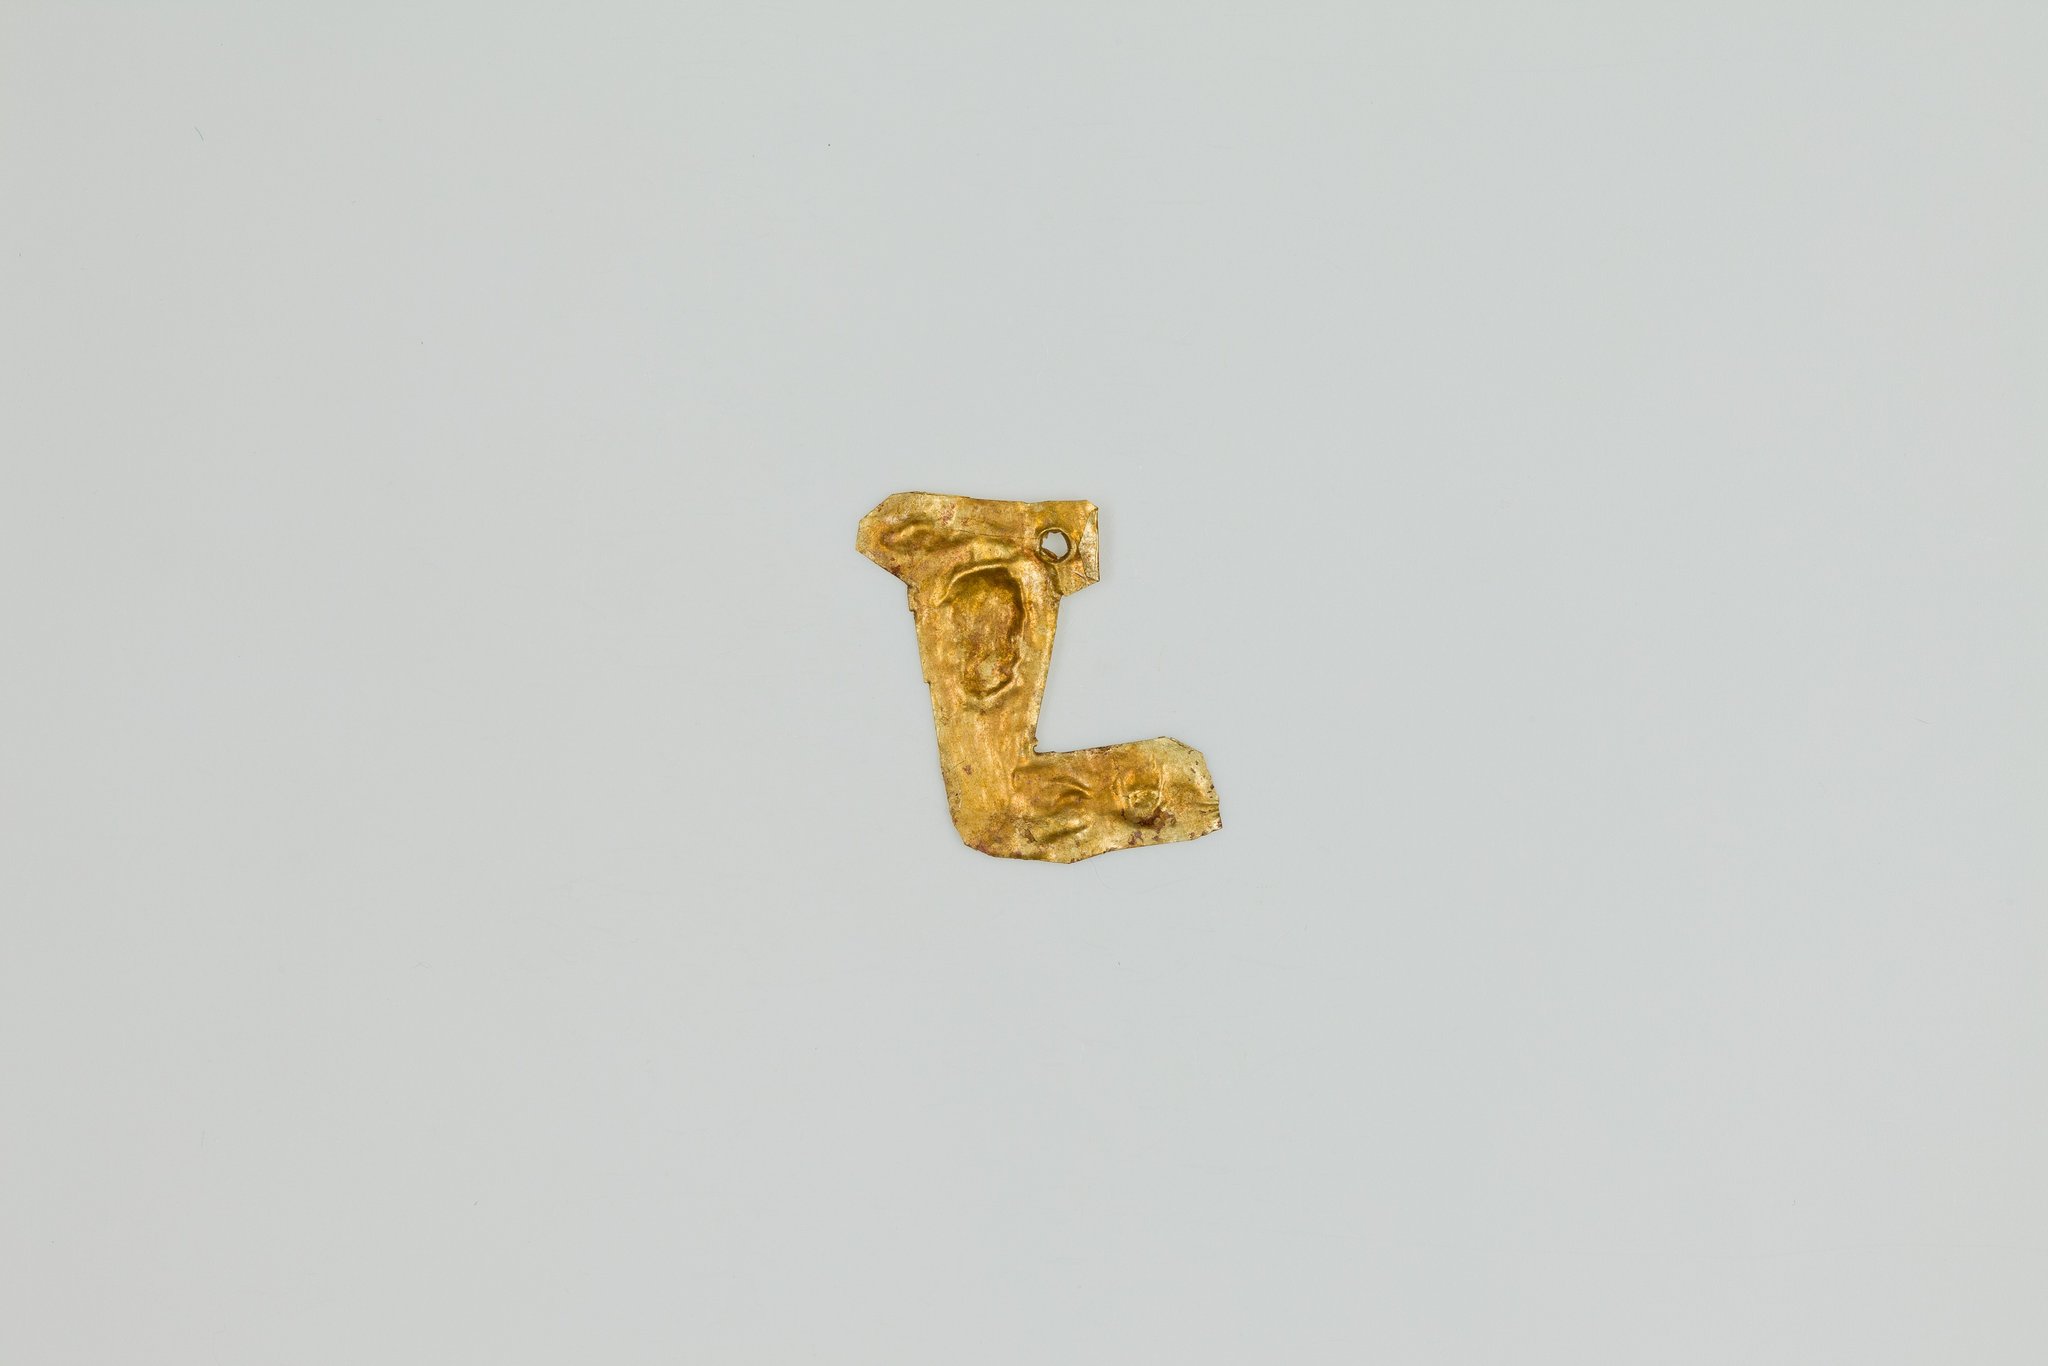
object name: amulet, uraeus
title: Uraeus amulet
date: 664-380 BCE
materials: gold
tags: serpents